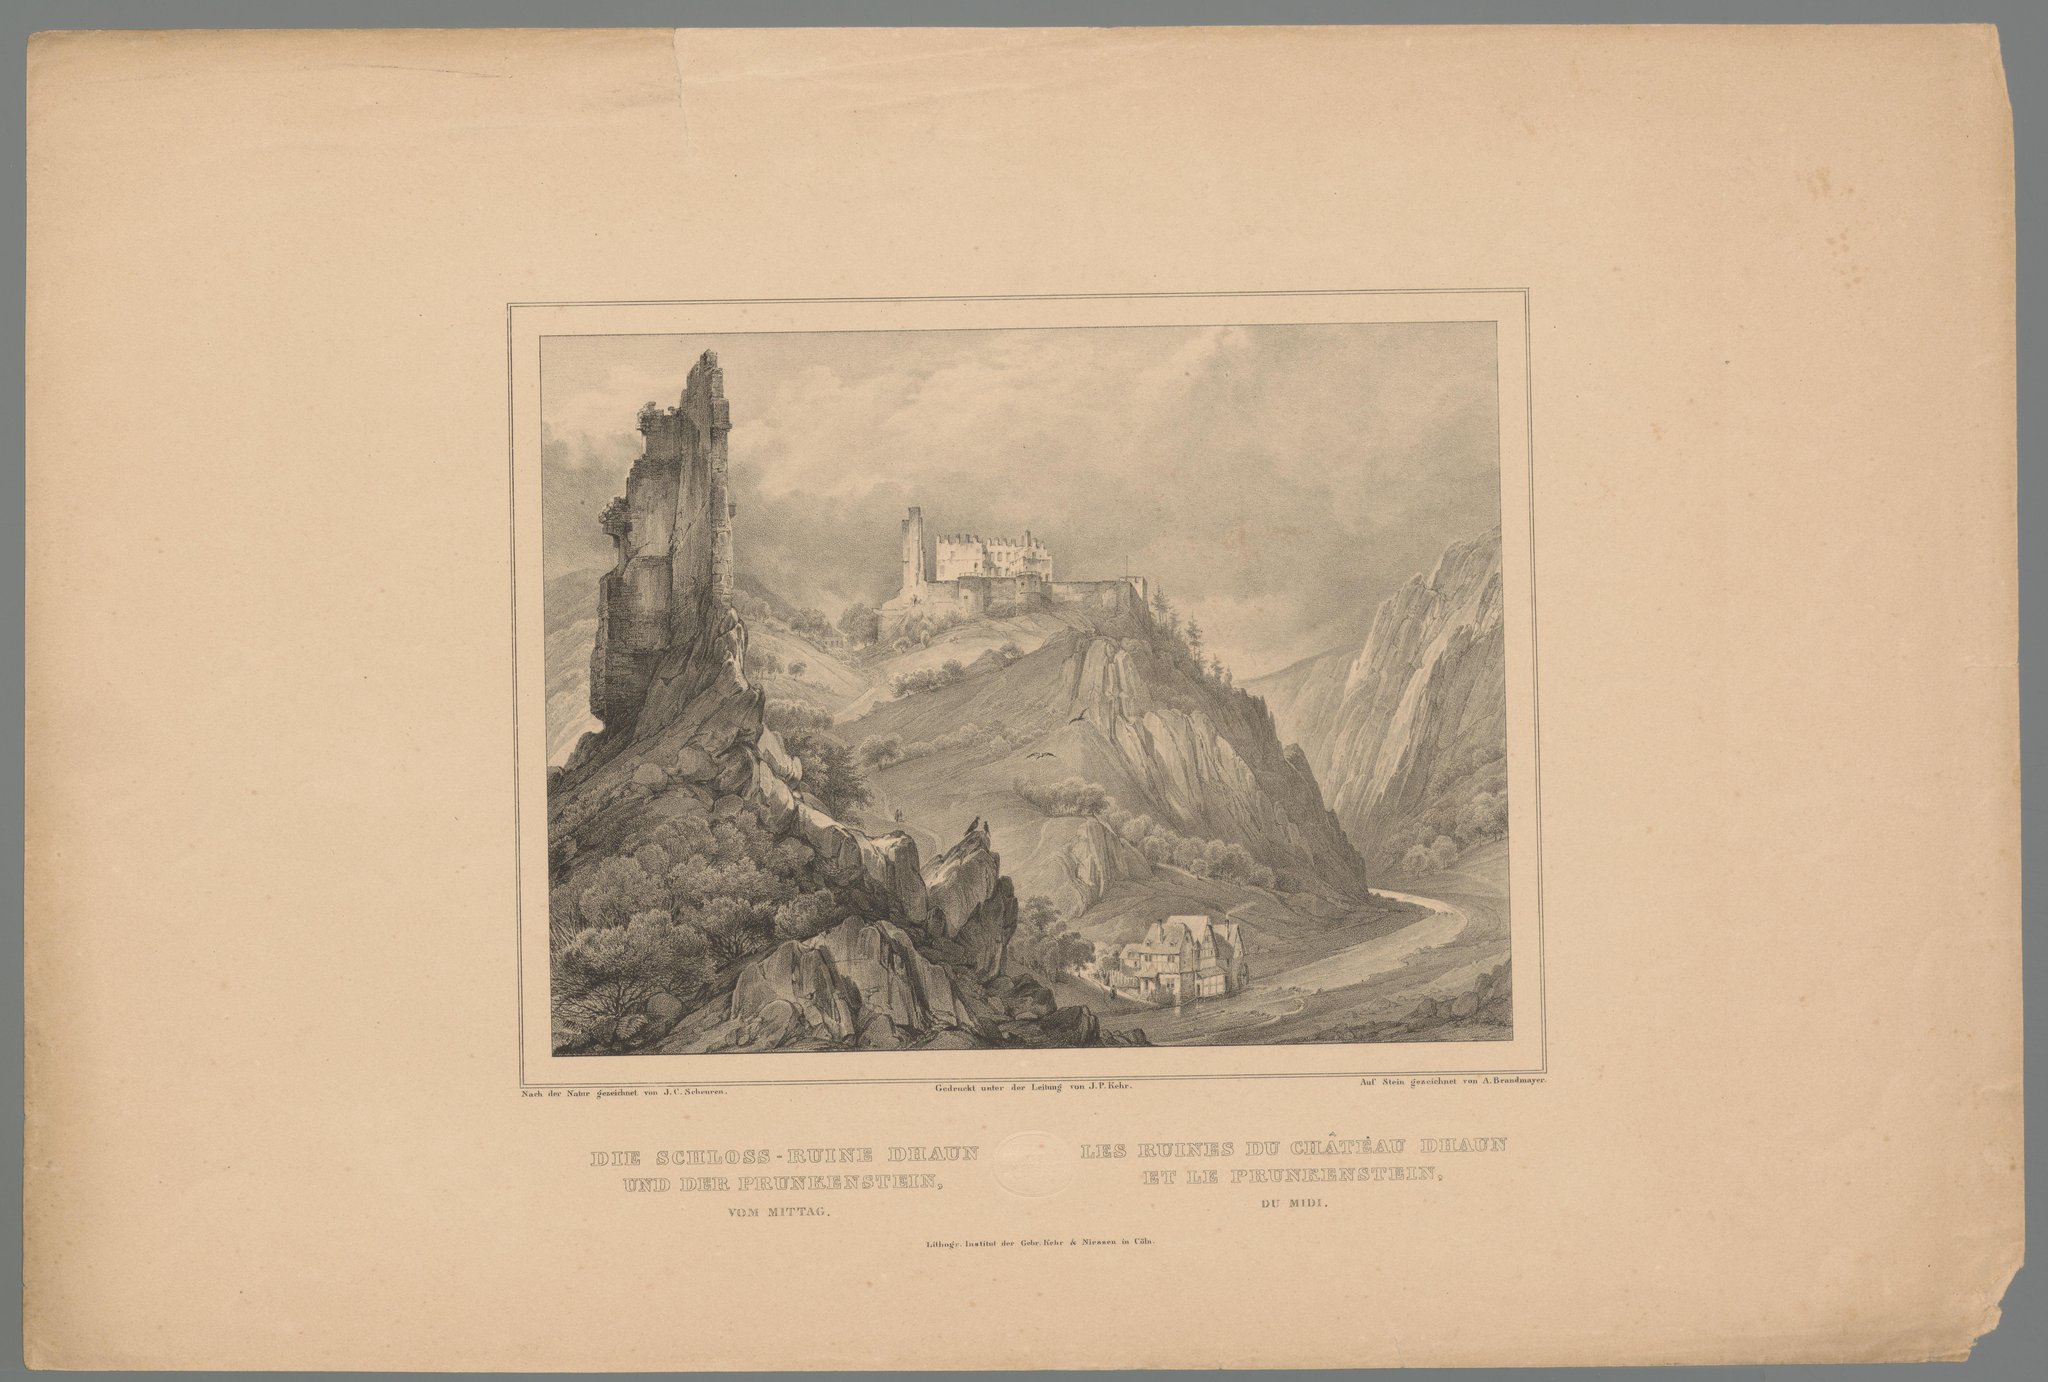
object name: print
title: Die Schloss-Ruine Dhaun und der Prunkenstein, vom Mittag / Les ruines du château Dhaun et le Prunkenstein, du midi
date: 1834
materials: paper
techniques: lithograph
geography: cologne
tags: landscape with ruins, rock-formations, ruin of a dwelling, house, castle, etc.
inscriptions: check stamp: ‘Verlag von L. Niessen in Cöln’, collector's mark: Lugt 2228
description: De serie 'Das Nahe-Thal. Von dem Ursprunge der Nahe bis zu ihrer Mündung in den Rhein' is uitgegeven in vijf delen van elk vier prenten vervaardigd door A. Brandmayer en Andreas Borum. Tien prenten uit deze serie zijn daarnaast waarschijnlijk ook nog samen onder de titel 'Kreuznach und seine Umgebung. Erinnerung an seine Heilquellen und das Nahe-Thal' uitgegeven.